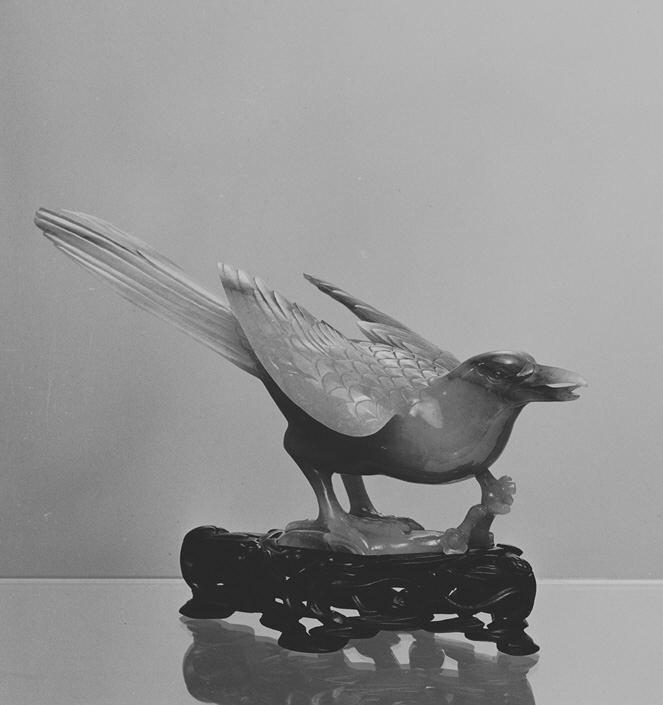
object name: figurine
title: Magpie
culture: chinese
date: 1701-1800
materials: jade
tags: birds